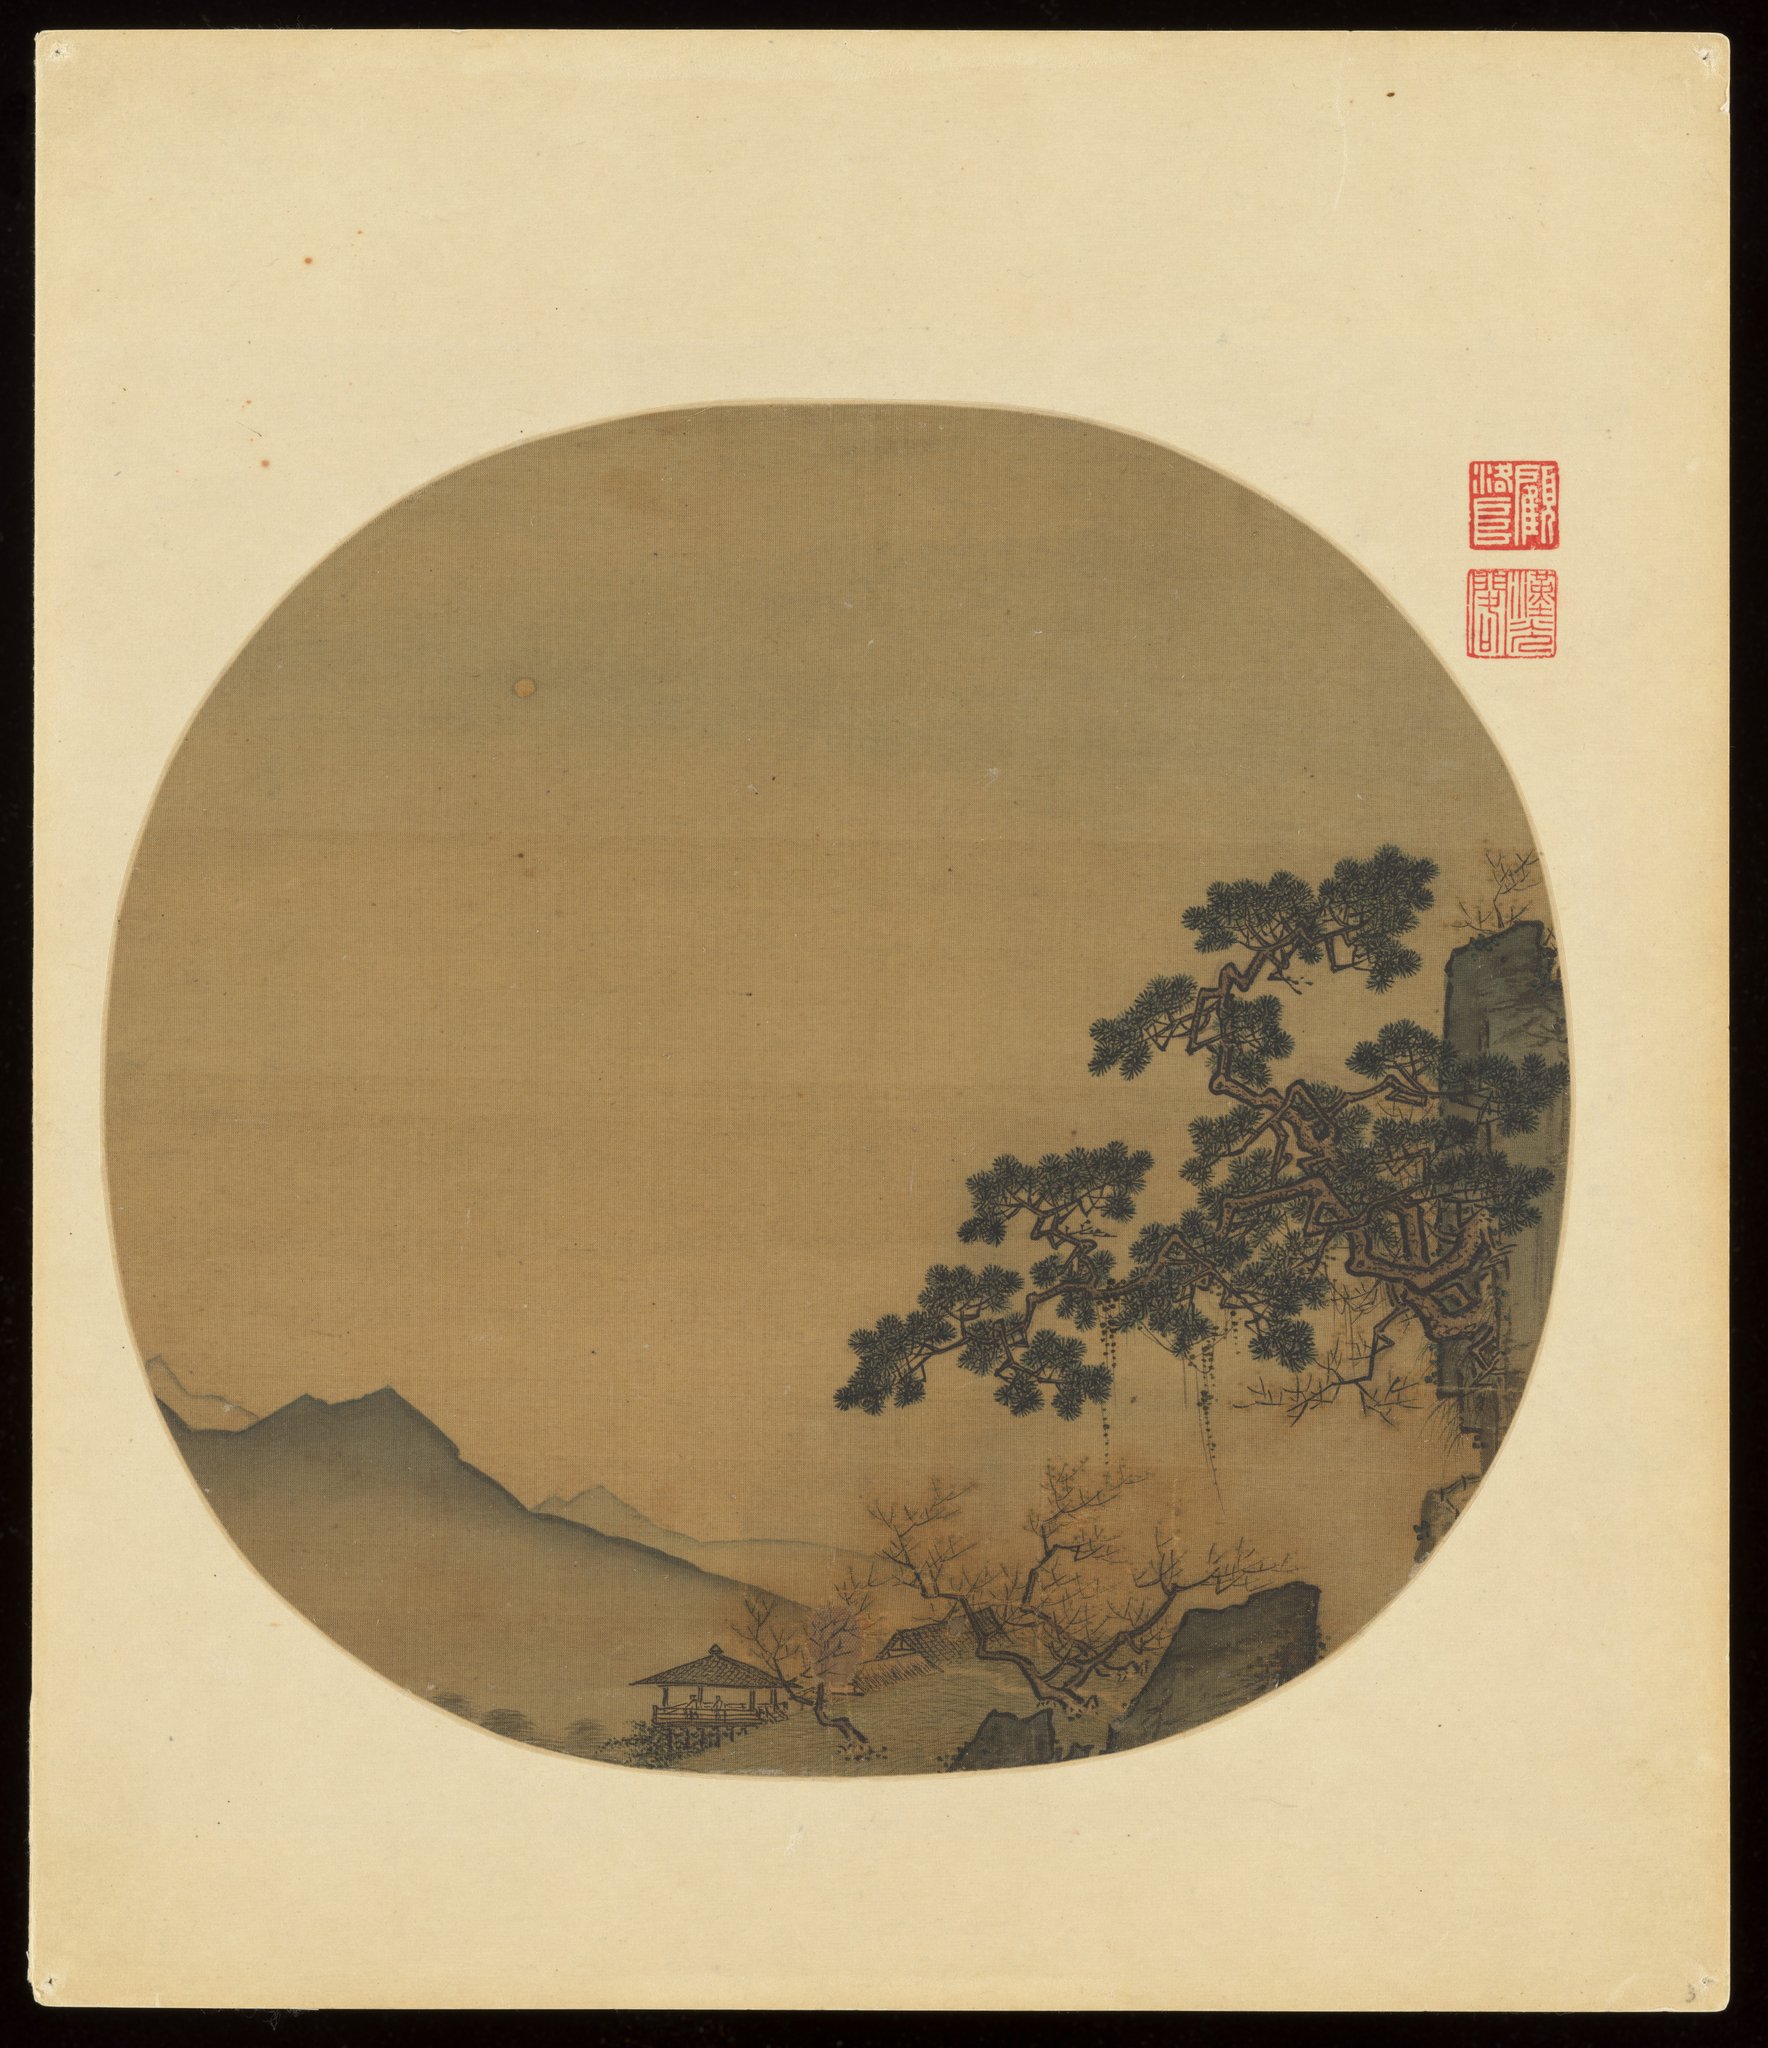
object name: folding fan mounted a an album leaf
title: Early spring landscape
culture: chinese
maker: unidentified artist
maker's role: artist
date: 1234-1266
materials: ink, silk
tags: landscapes,trees